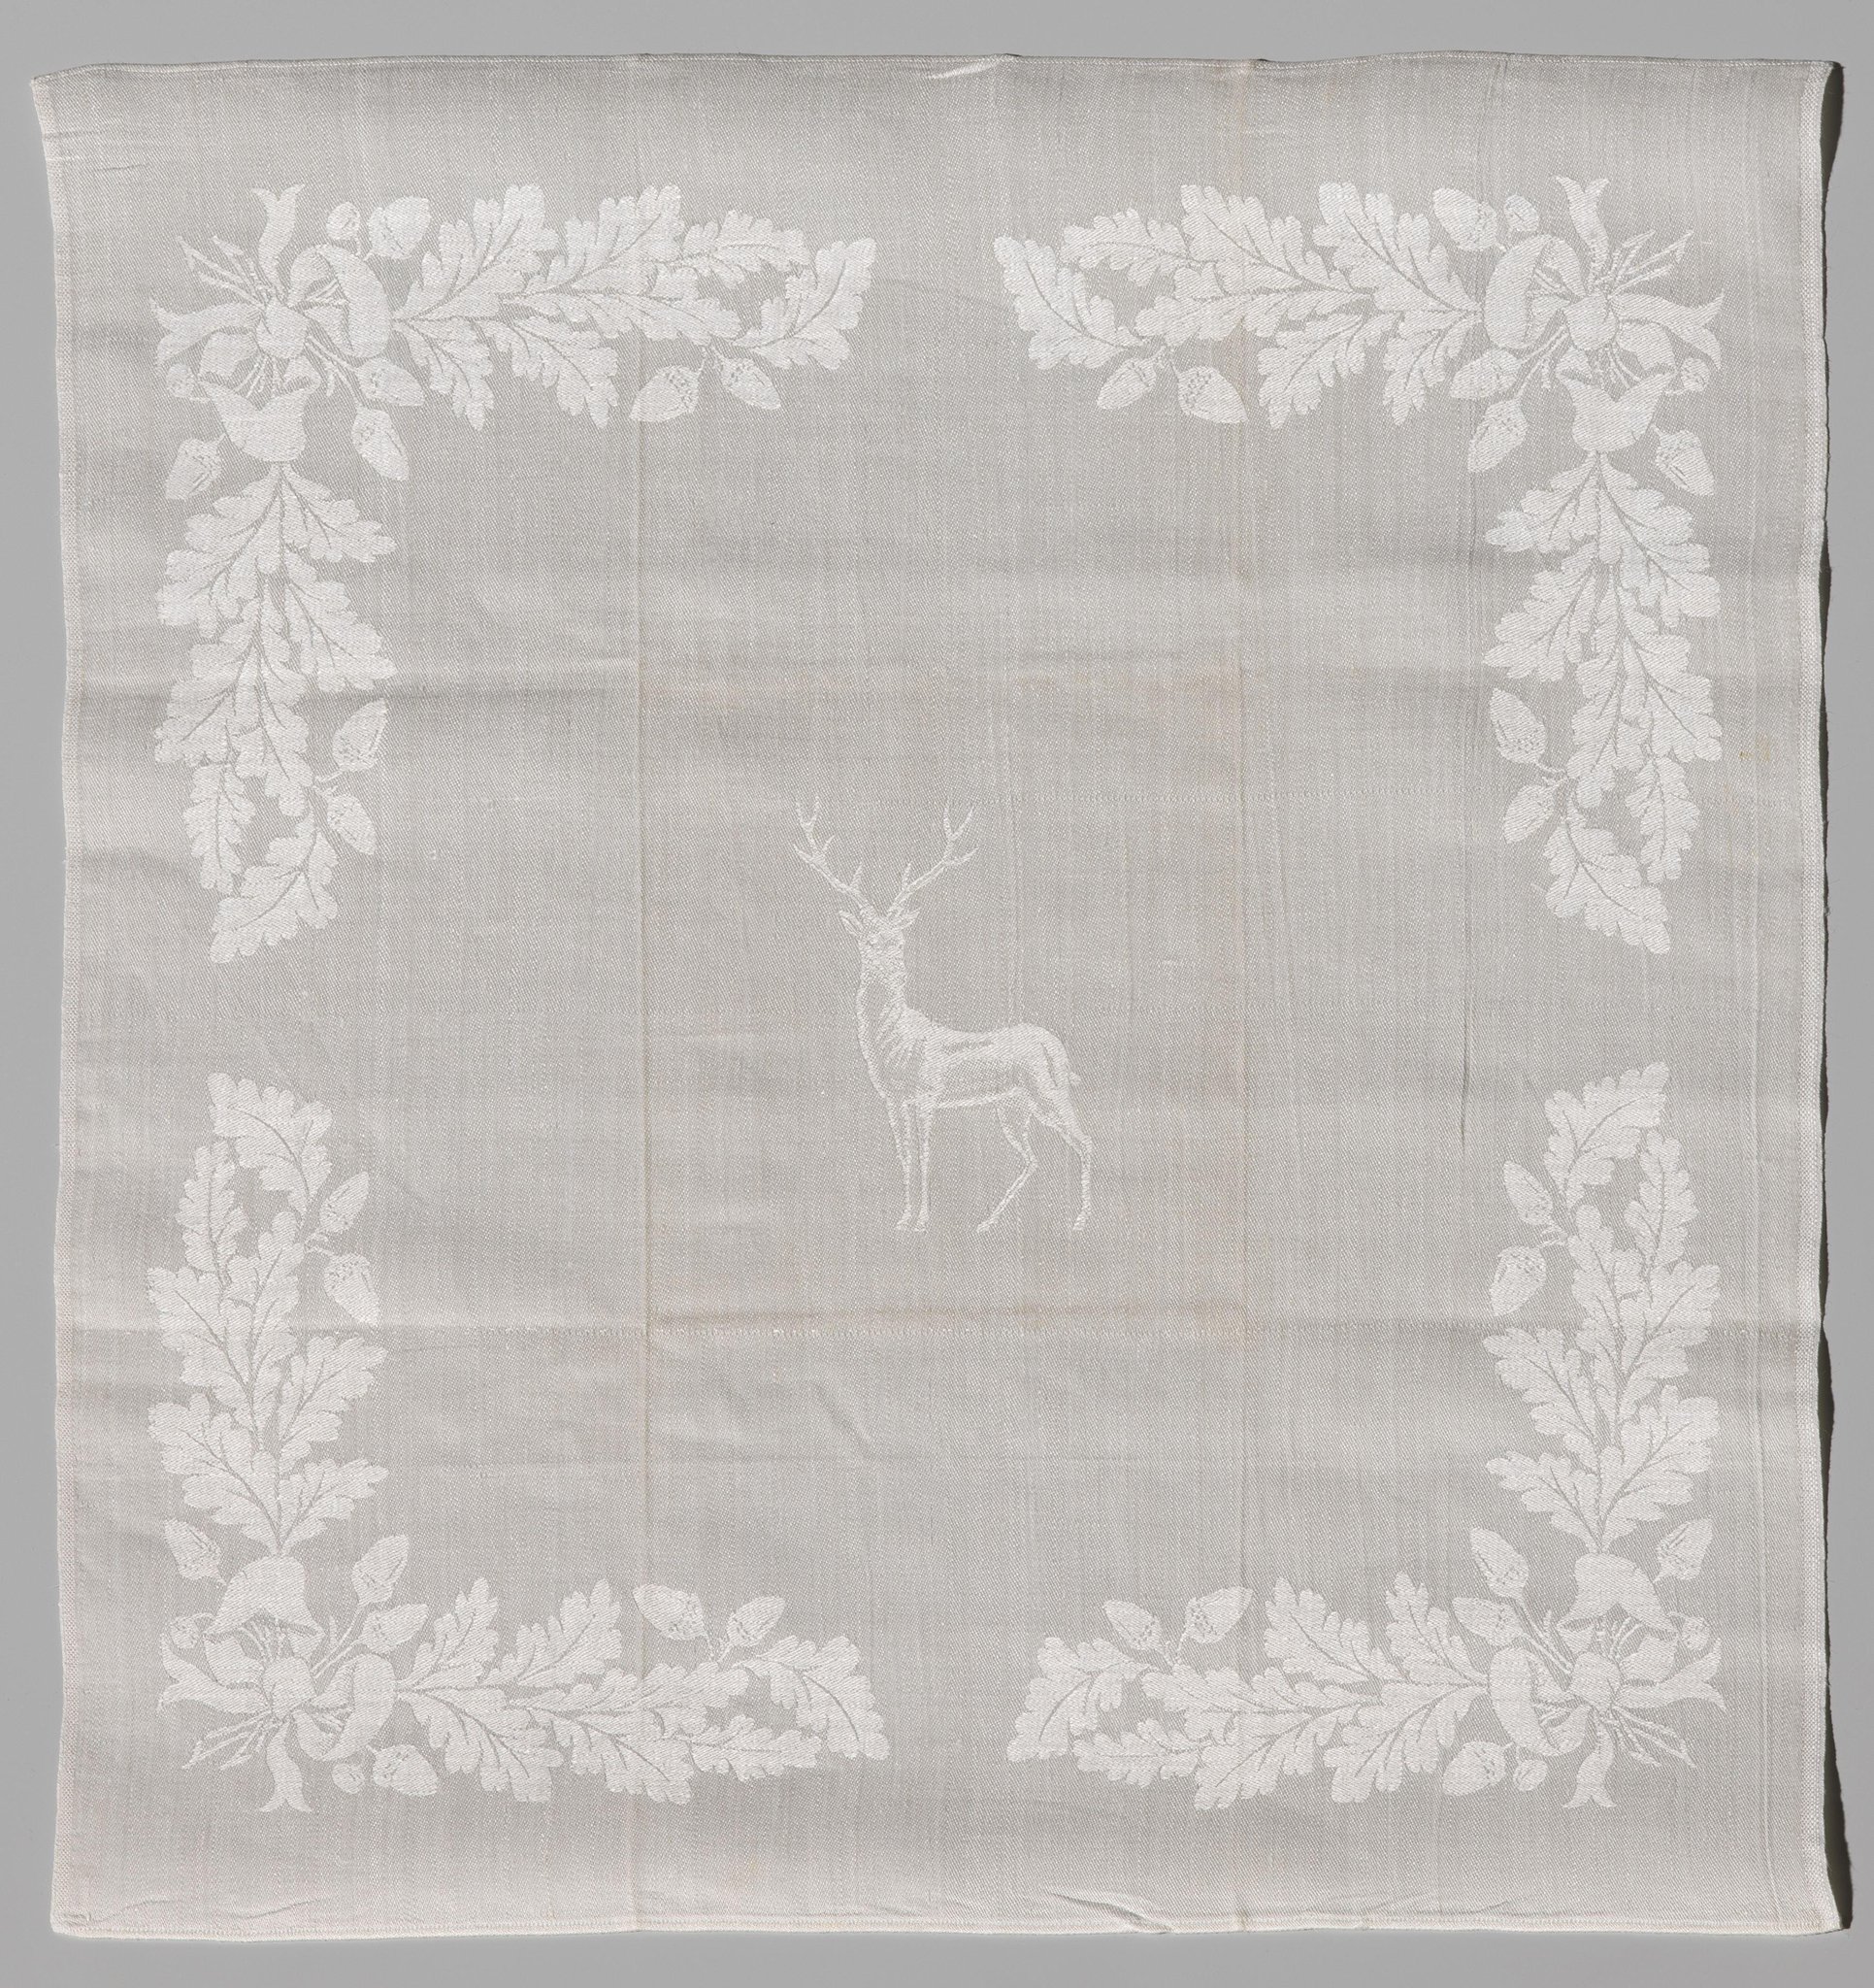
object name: napkin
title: Servet van linnendamast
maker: Anonymous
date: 1850-1950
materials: linen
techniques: damask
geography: eindhoven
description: Linnen damasten servet met een hert in het midden en eiketakken in de randen.